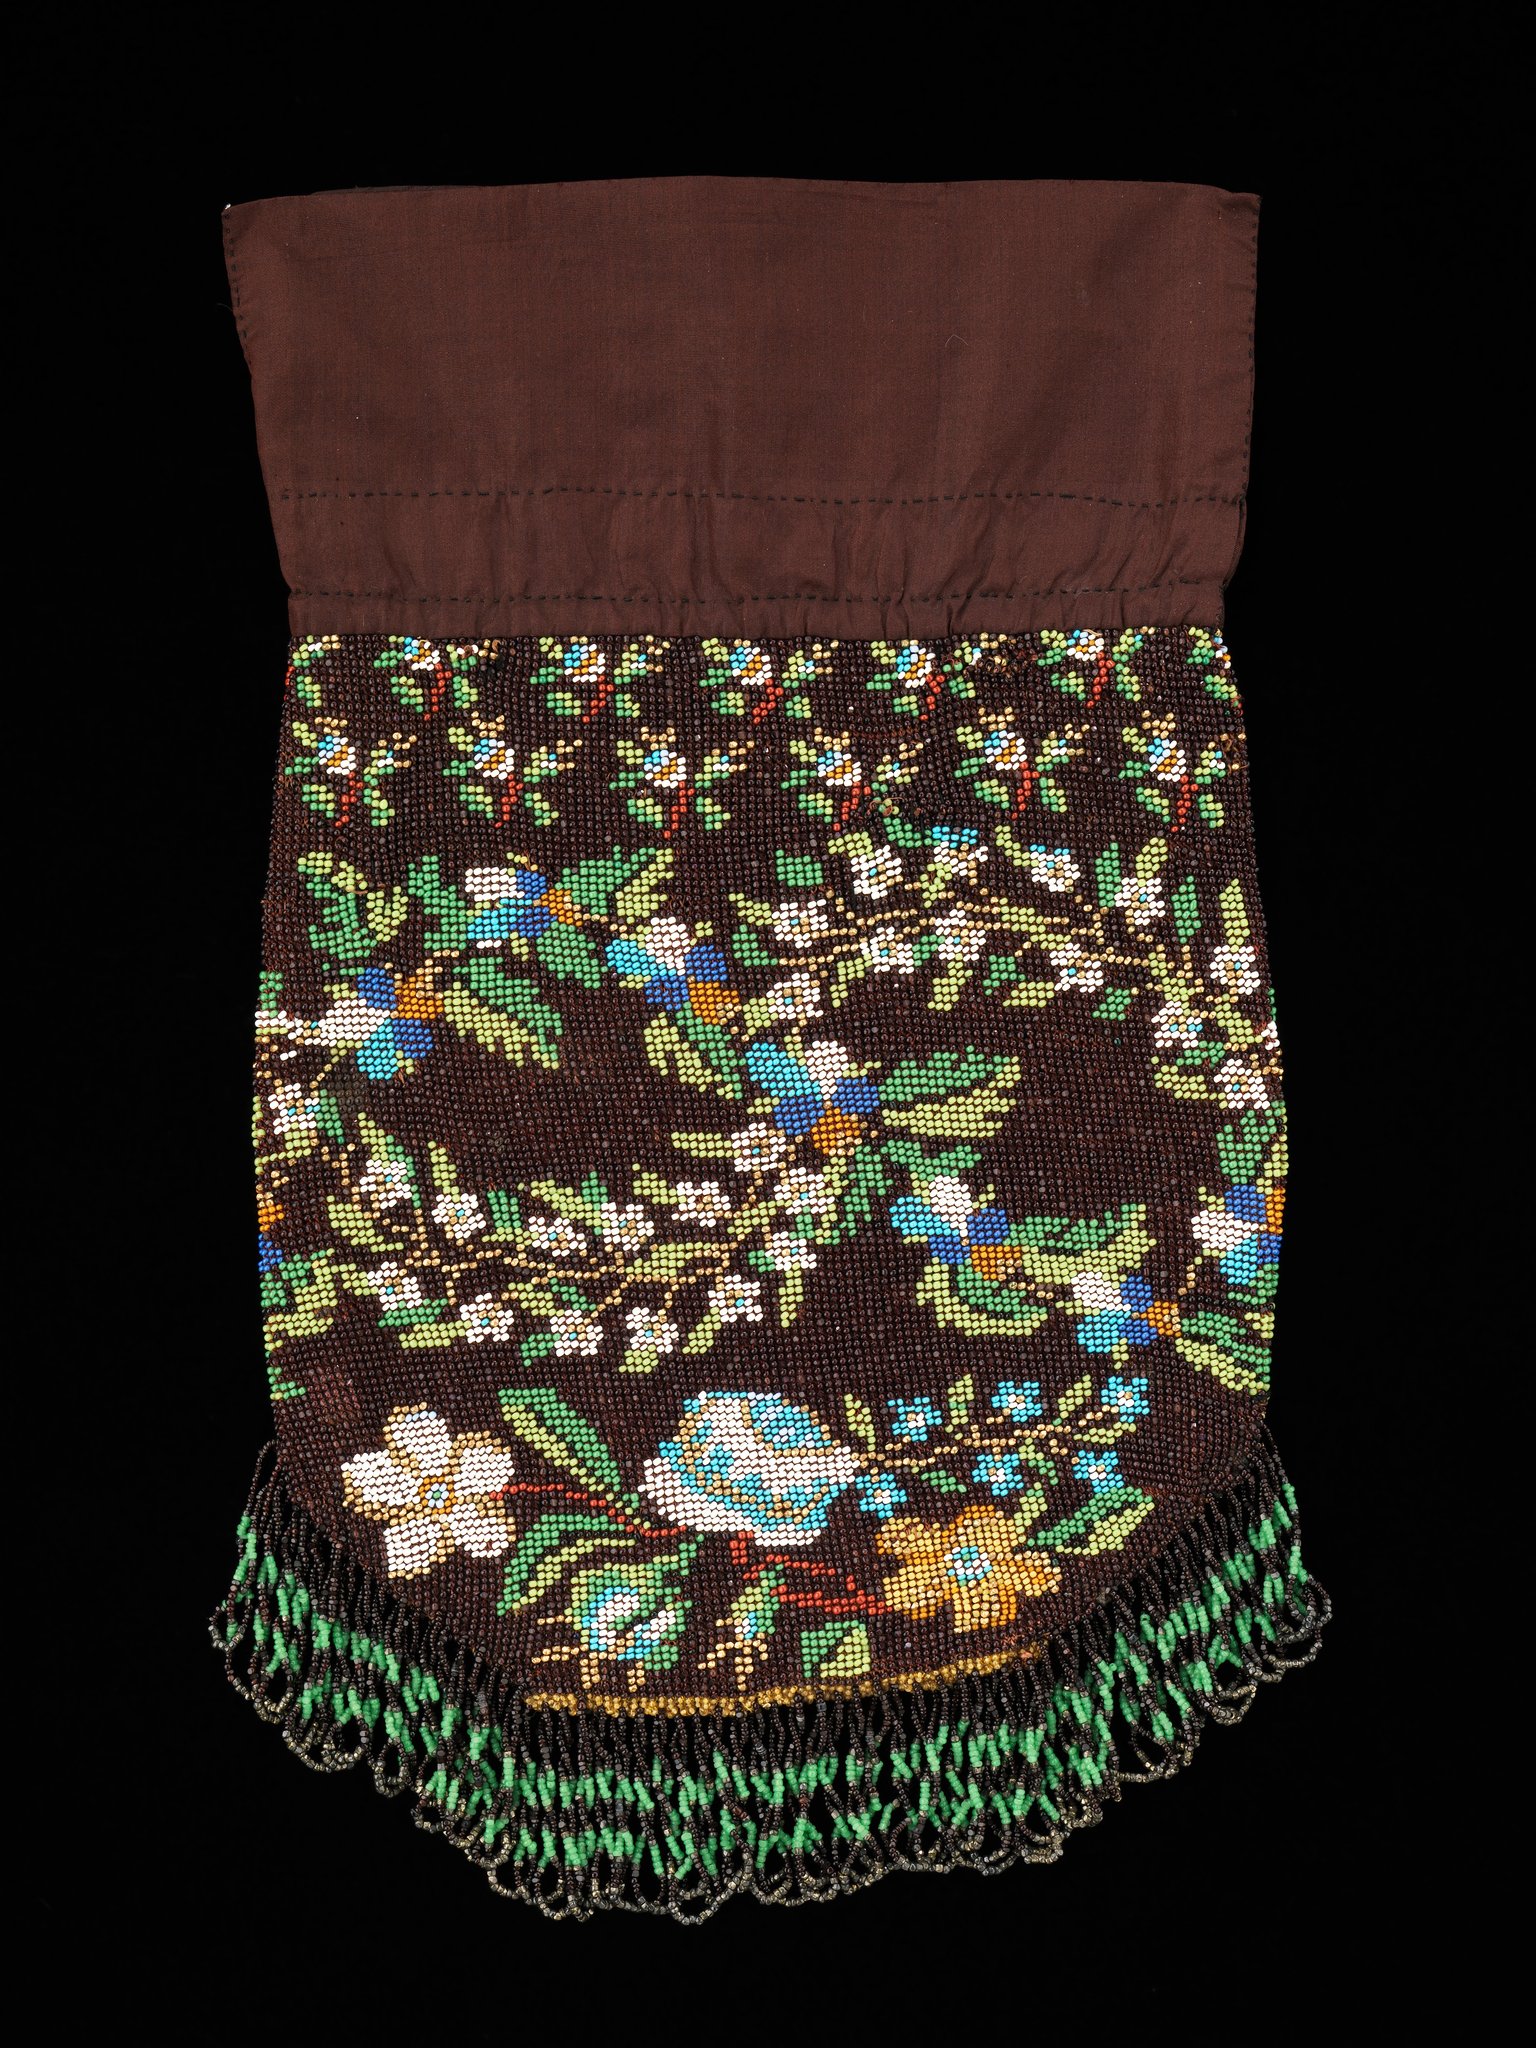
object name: evening pouch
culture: american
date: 1851-1875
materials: glass, silk